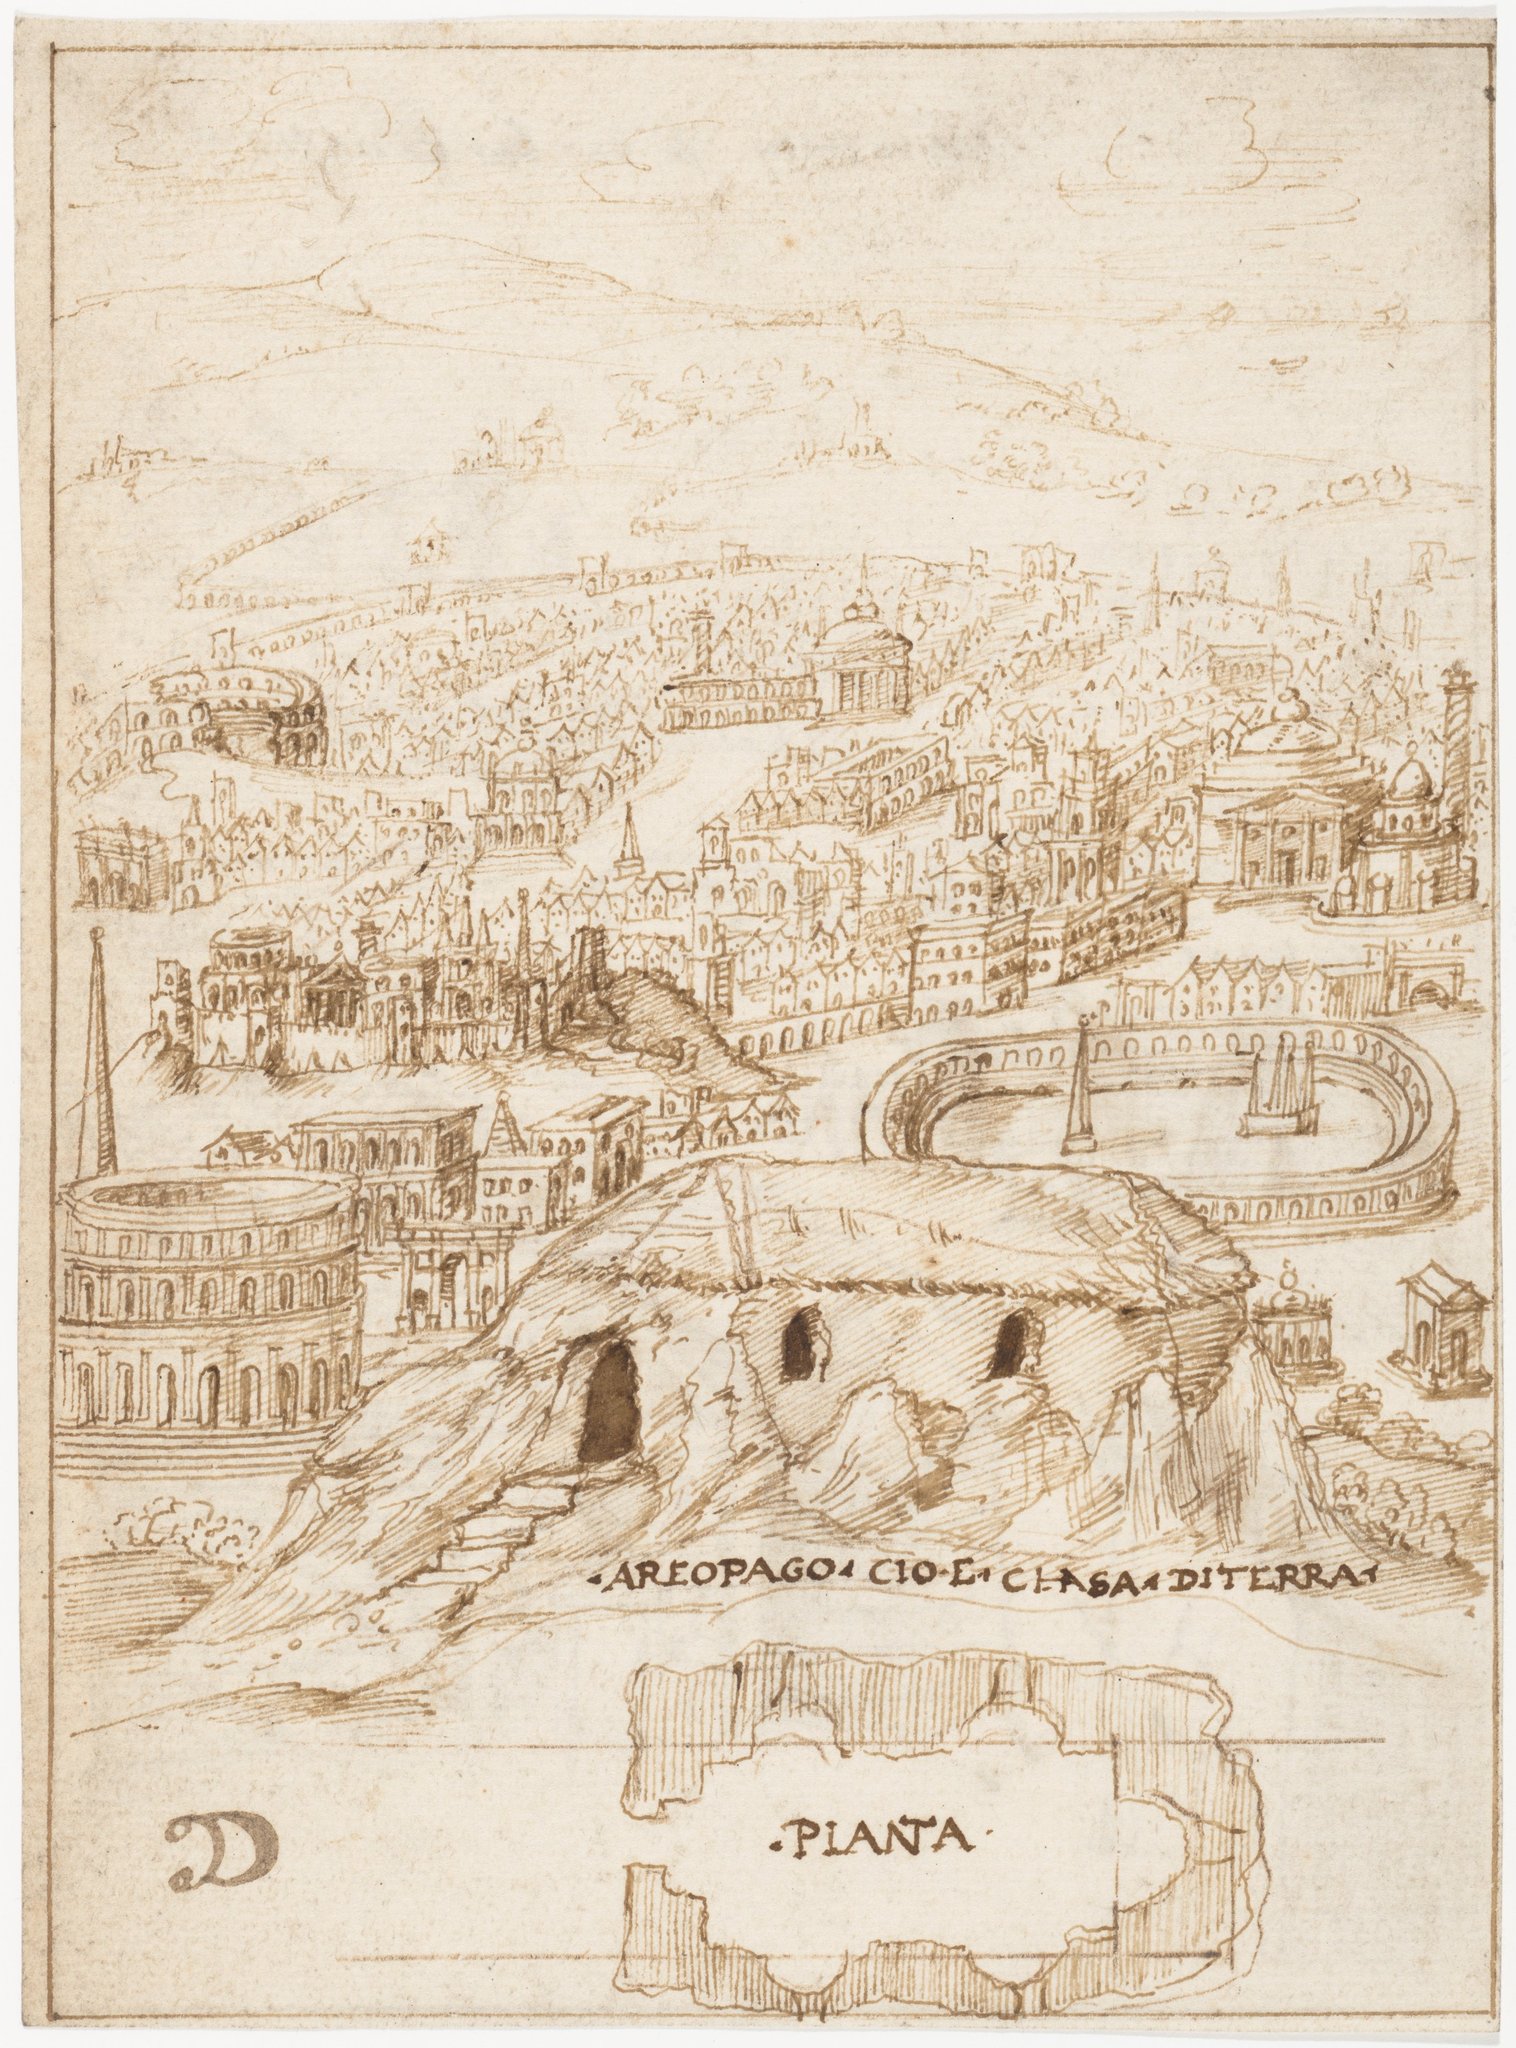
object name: drawing ornament architecture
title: Recto: The Houses of the Barbarians (Vitruvius, Book 2, Chapter 1, nos. 3, 4); Verso: The Aeropagus in Athens with Cave Houses (Vitruvius, Book 2, Chapter 1, no. 5).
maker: sangallo family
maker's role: artist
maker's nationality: italian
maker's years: 1530-1545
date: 1530-1545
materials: ink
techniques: pen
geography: france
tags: cities